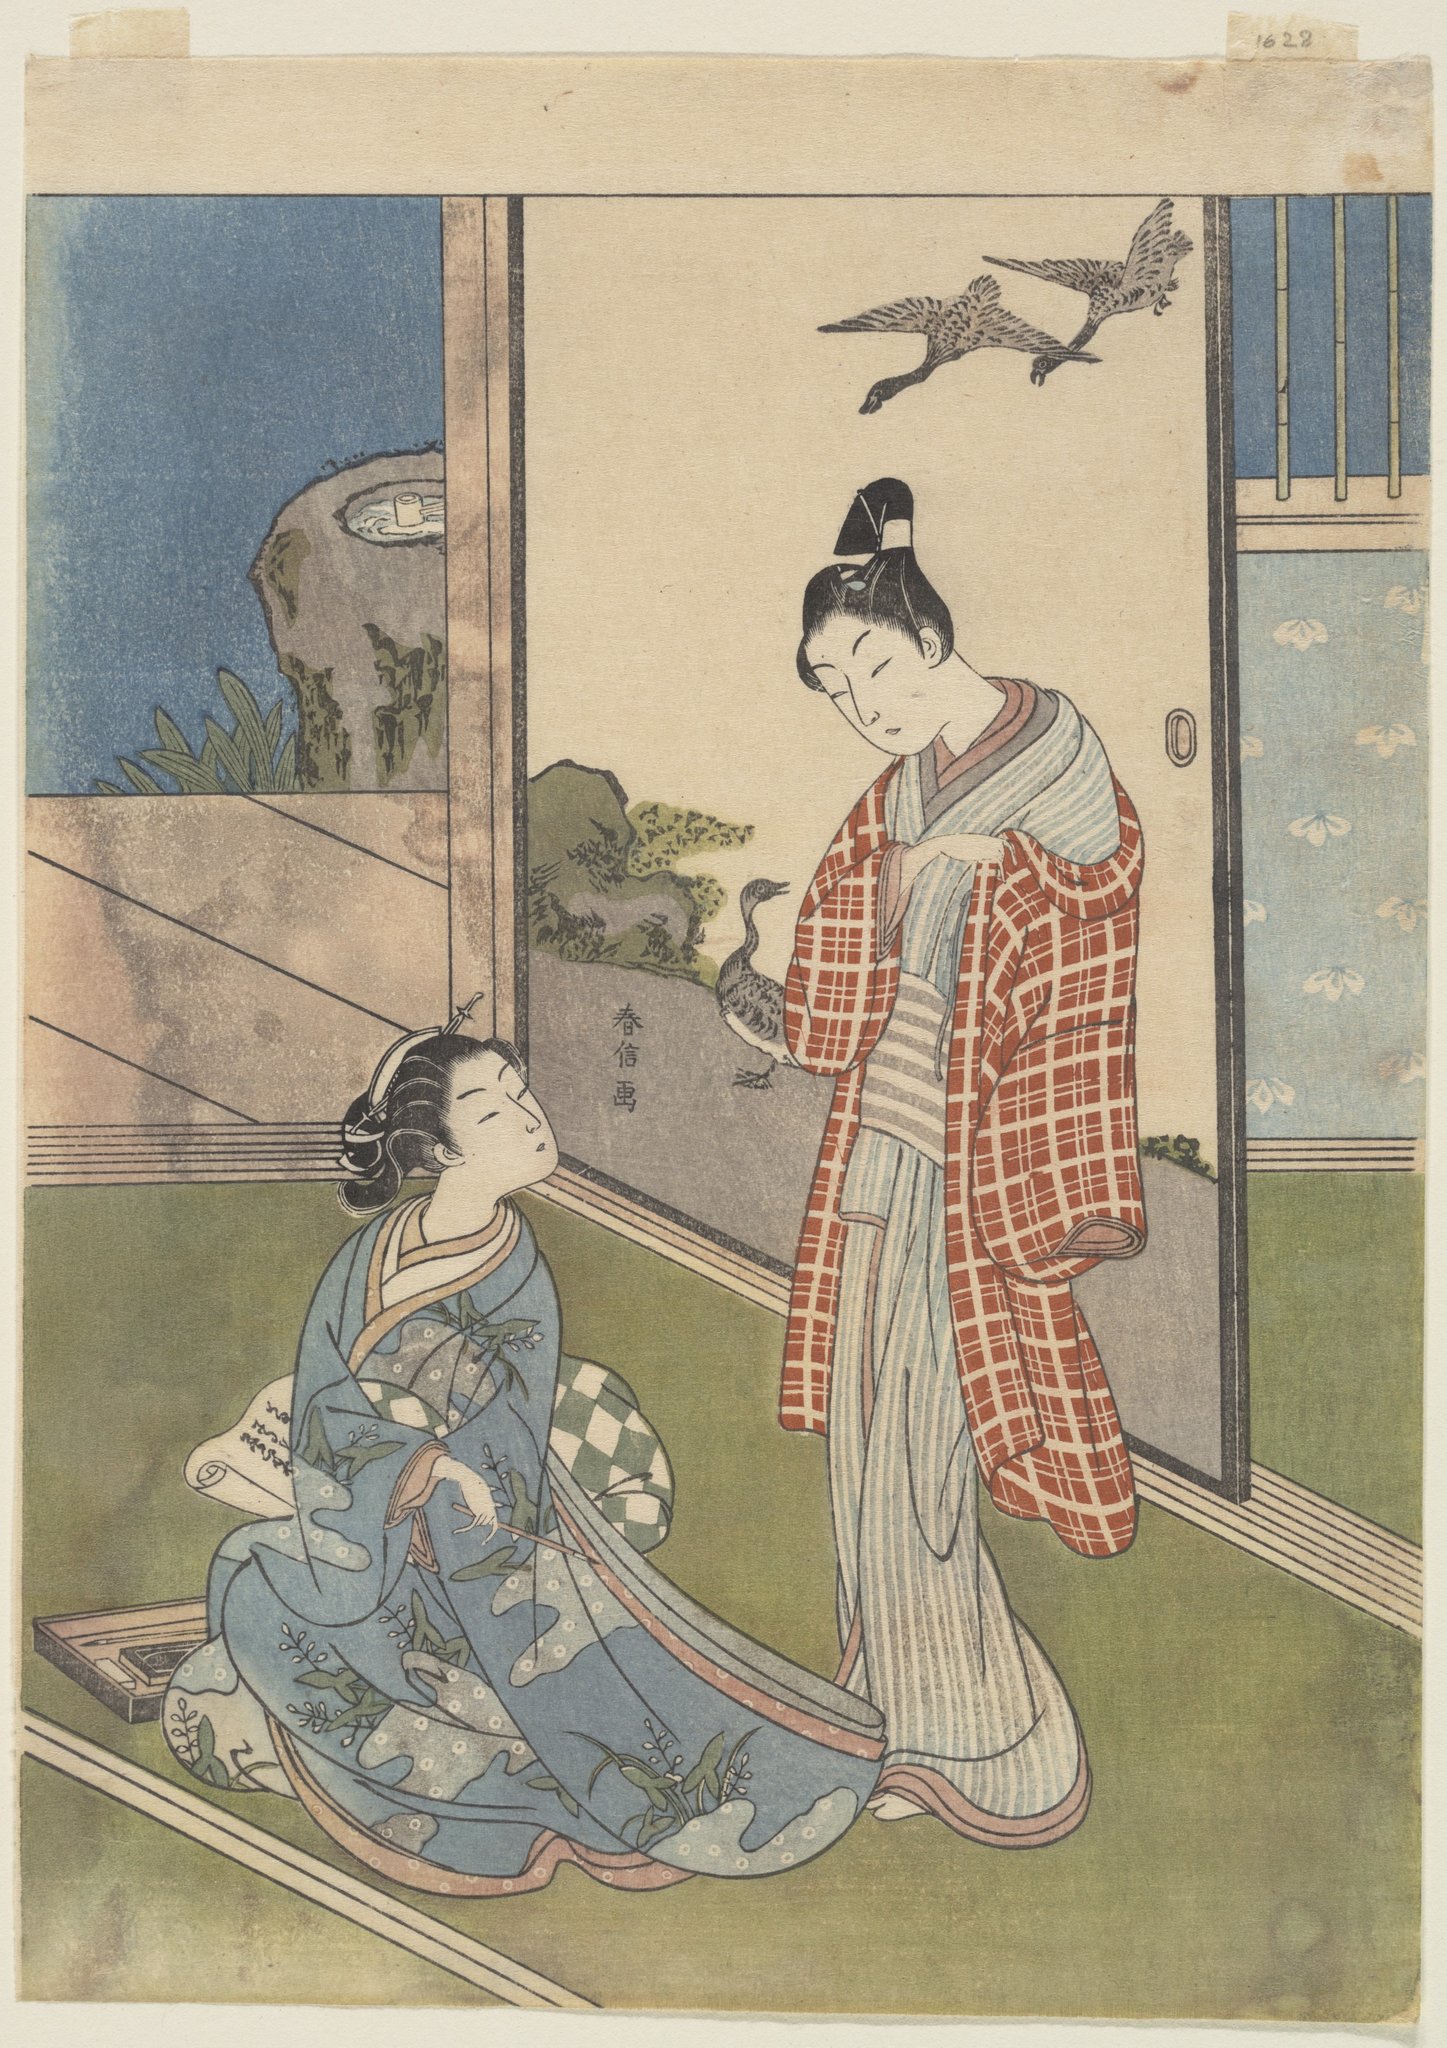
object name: print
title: A Girl Writing a Letter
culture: japanese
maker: suzuki harunobu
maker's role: artist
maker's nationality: japanese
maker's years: 1725-1770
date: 1701-1800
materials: ink, paper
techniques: woodblock print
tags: girls,men